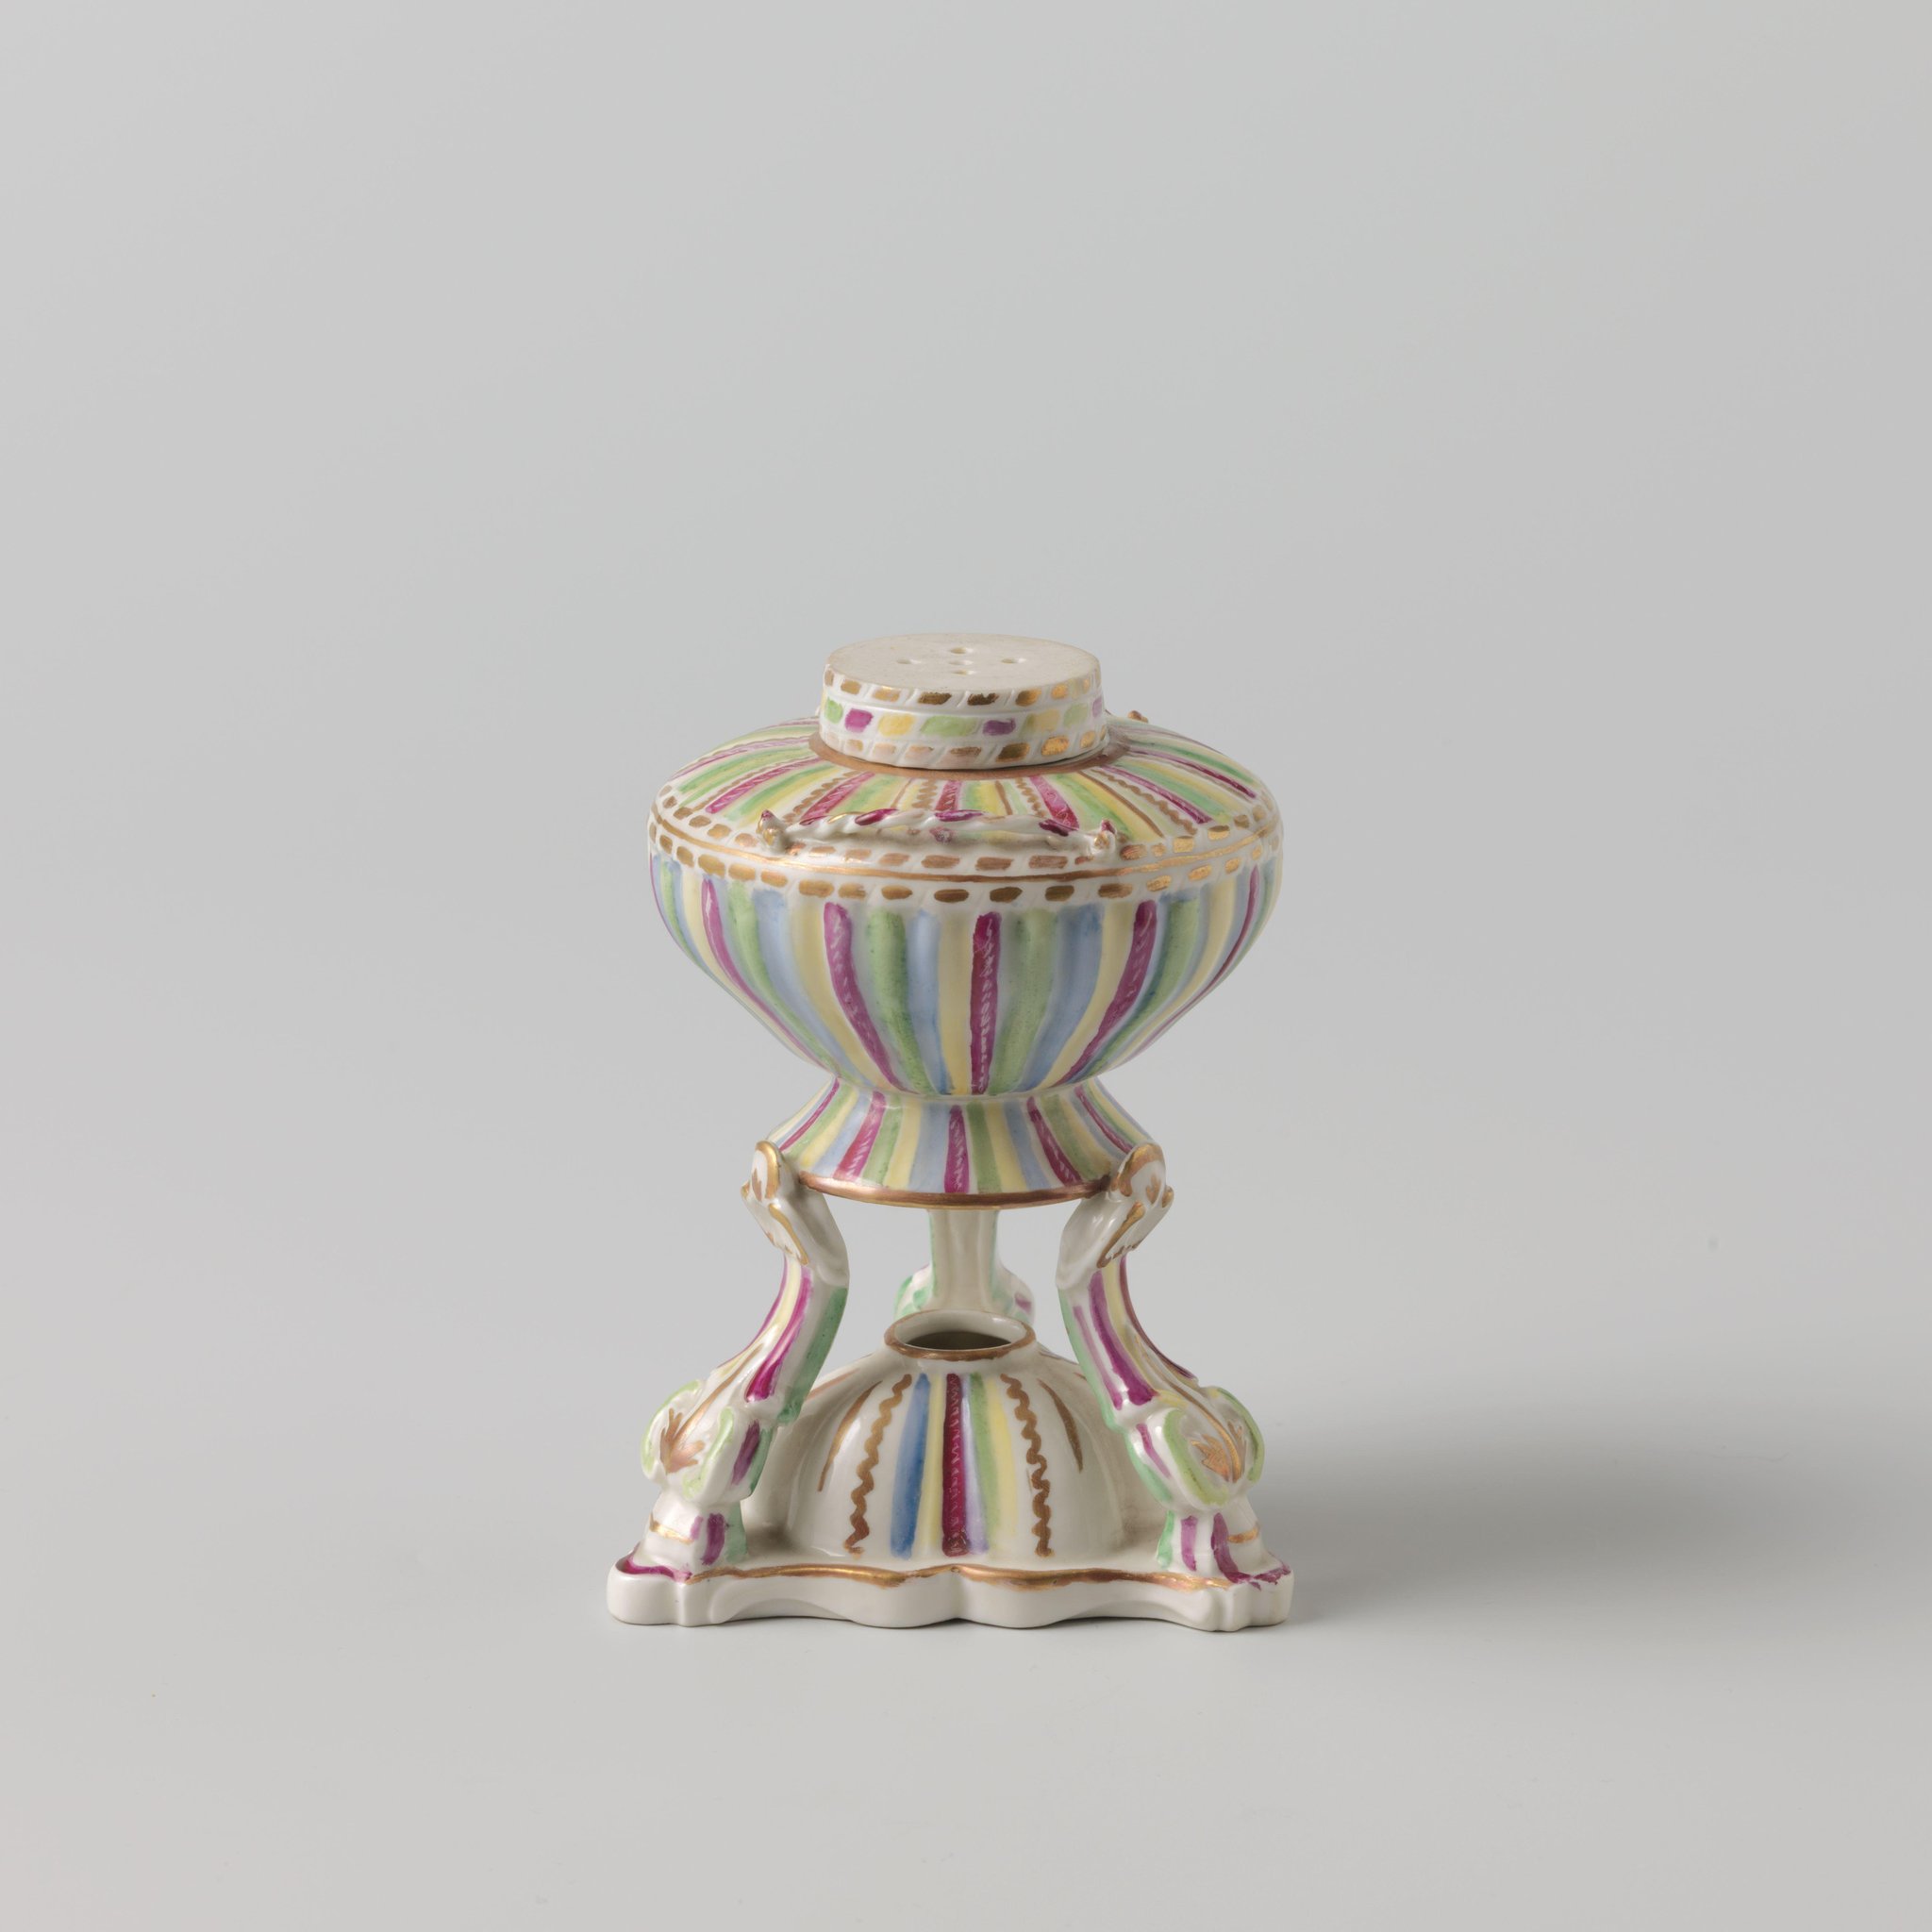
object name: incense burner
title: Wierookbrander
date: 1777-1790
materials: porcelain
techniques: painted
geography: the hague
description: Wierookbrander zonder deksel, bestaande uit een geribd potje op drie poten versierd met rocaille voluten en bladeren in relief. Het potje is versierd met veelkleurige strepen. Niet gemerkt.